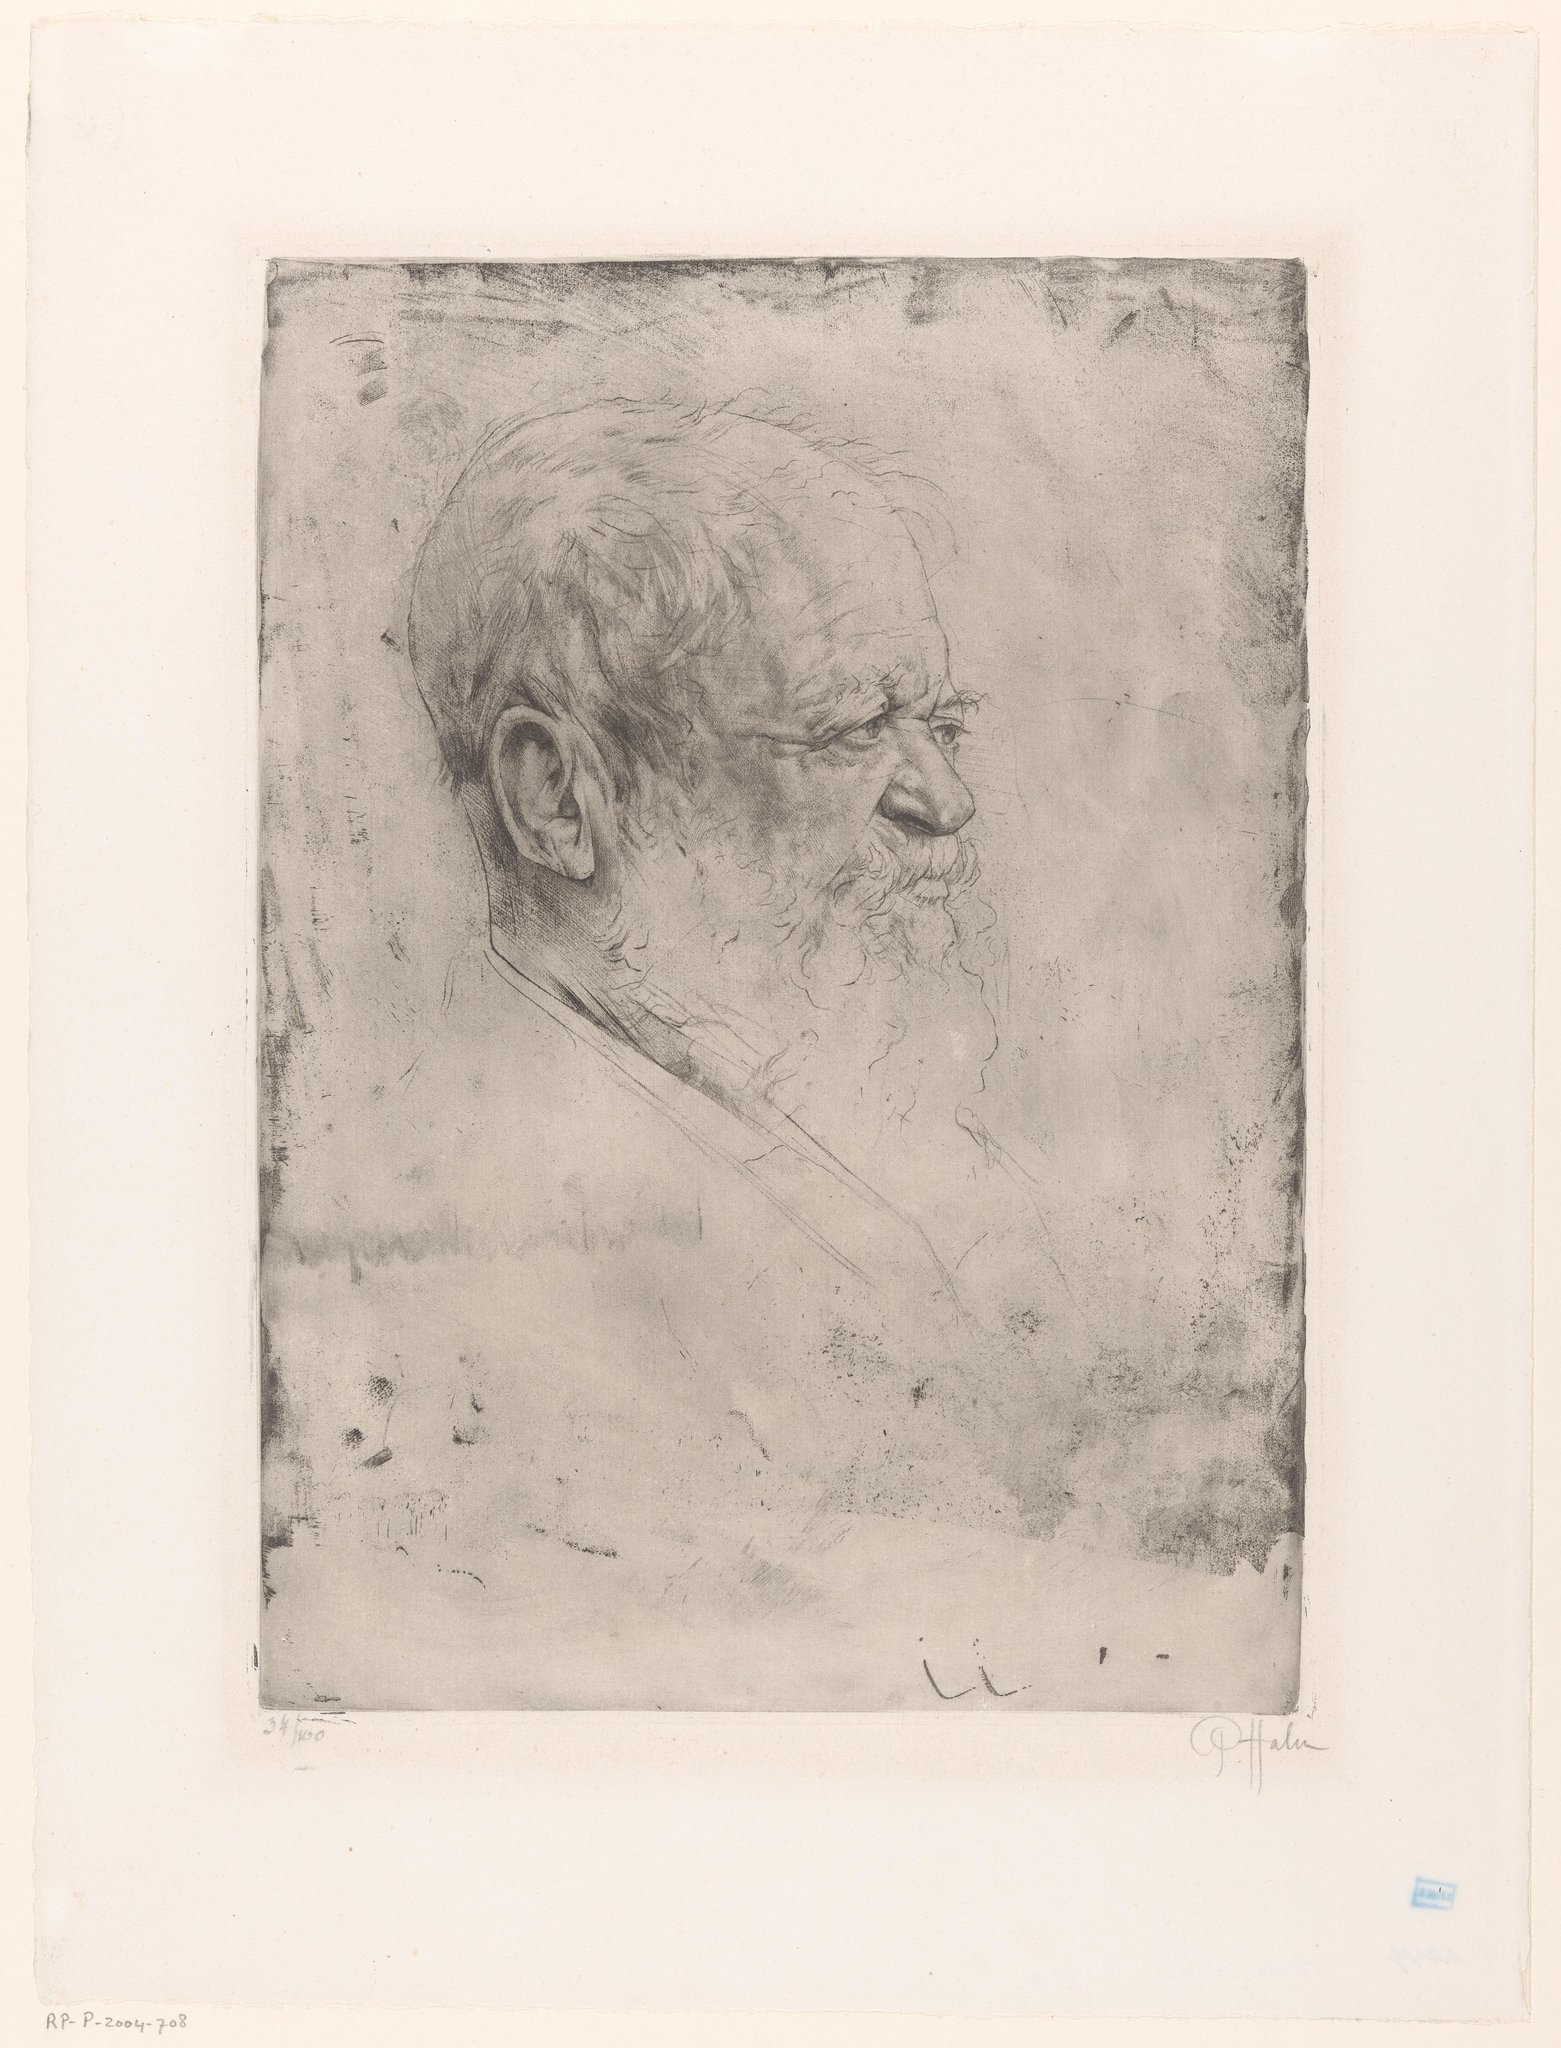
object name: print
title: Portret van een onbekende man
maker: peter von halm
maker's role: print maker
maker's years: 1854-1923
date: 1864-1923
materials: paper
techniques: intaglio, soft ground etching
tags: anonymous historical person portrayed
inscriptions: collector's mark: ‘Onleesbare naam.’, collector's mark: Lugt 2228, collector's mark: Lugt 3761